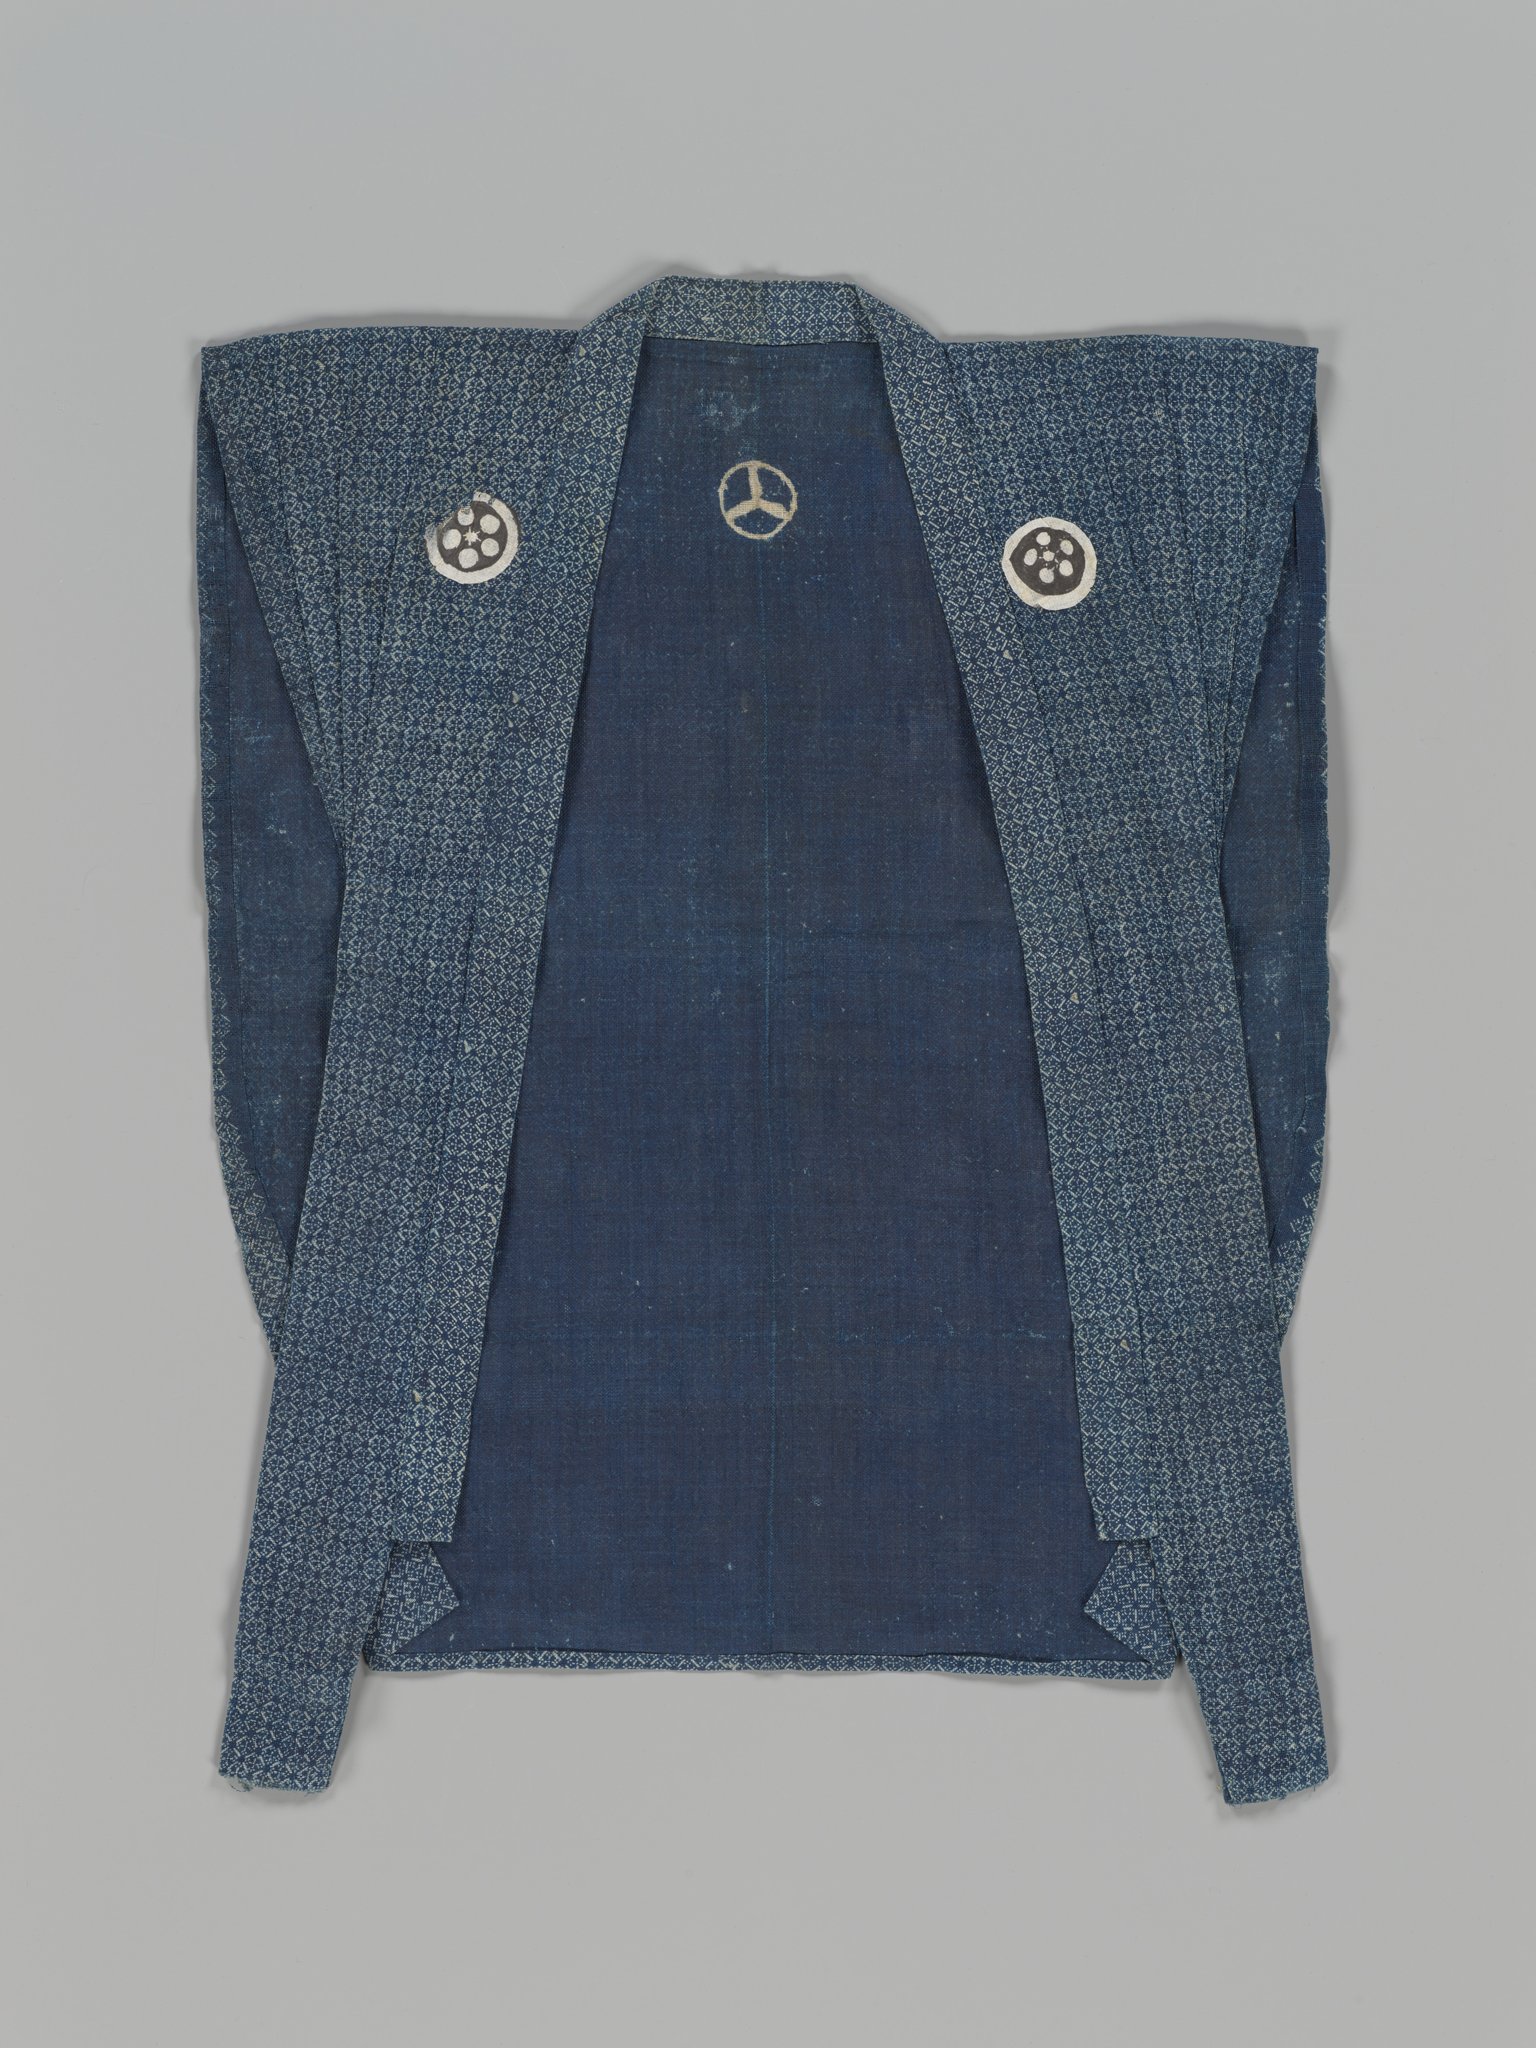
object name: child's ensemble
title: Child’s formal ensemble (kamishimo)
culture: japanese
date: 1801-1833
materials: fiber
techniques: weave